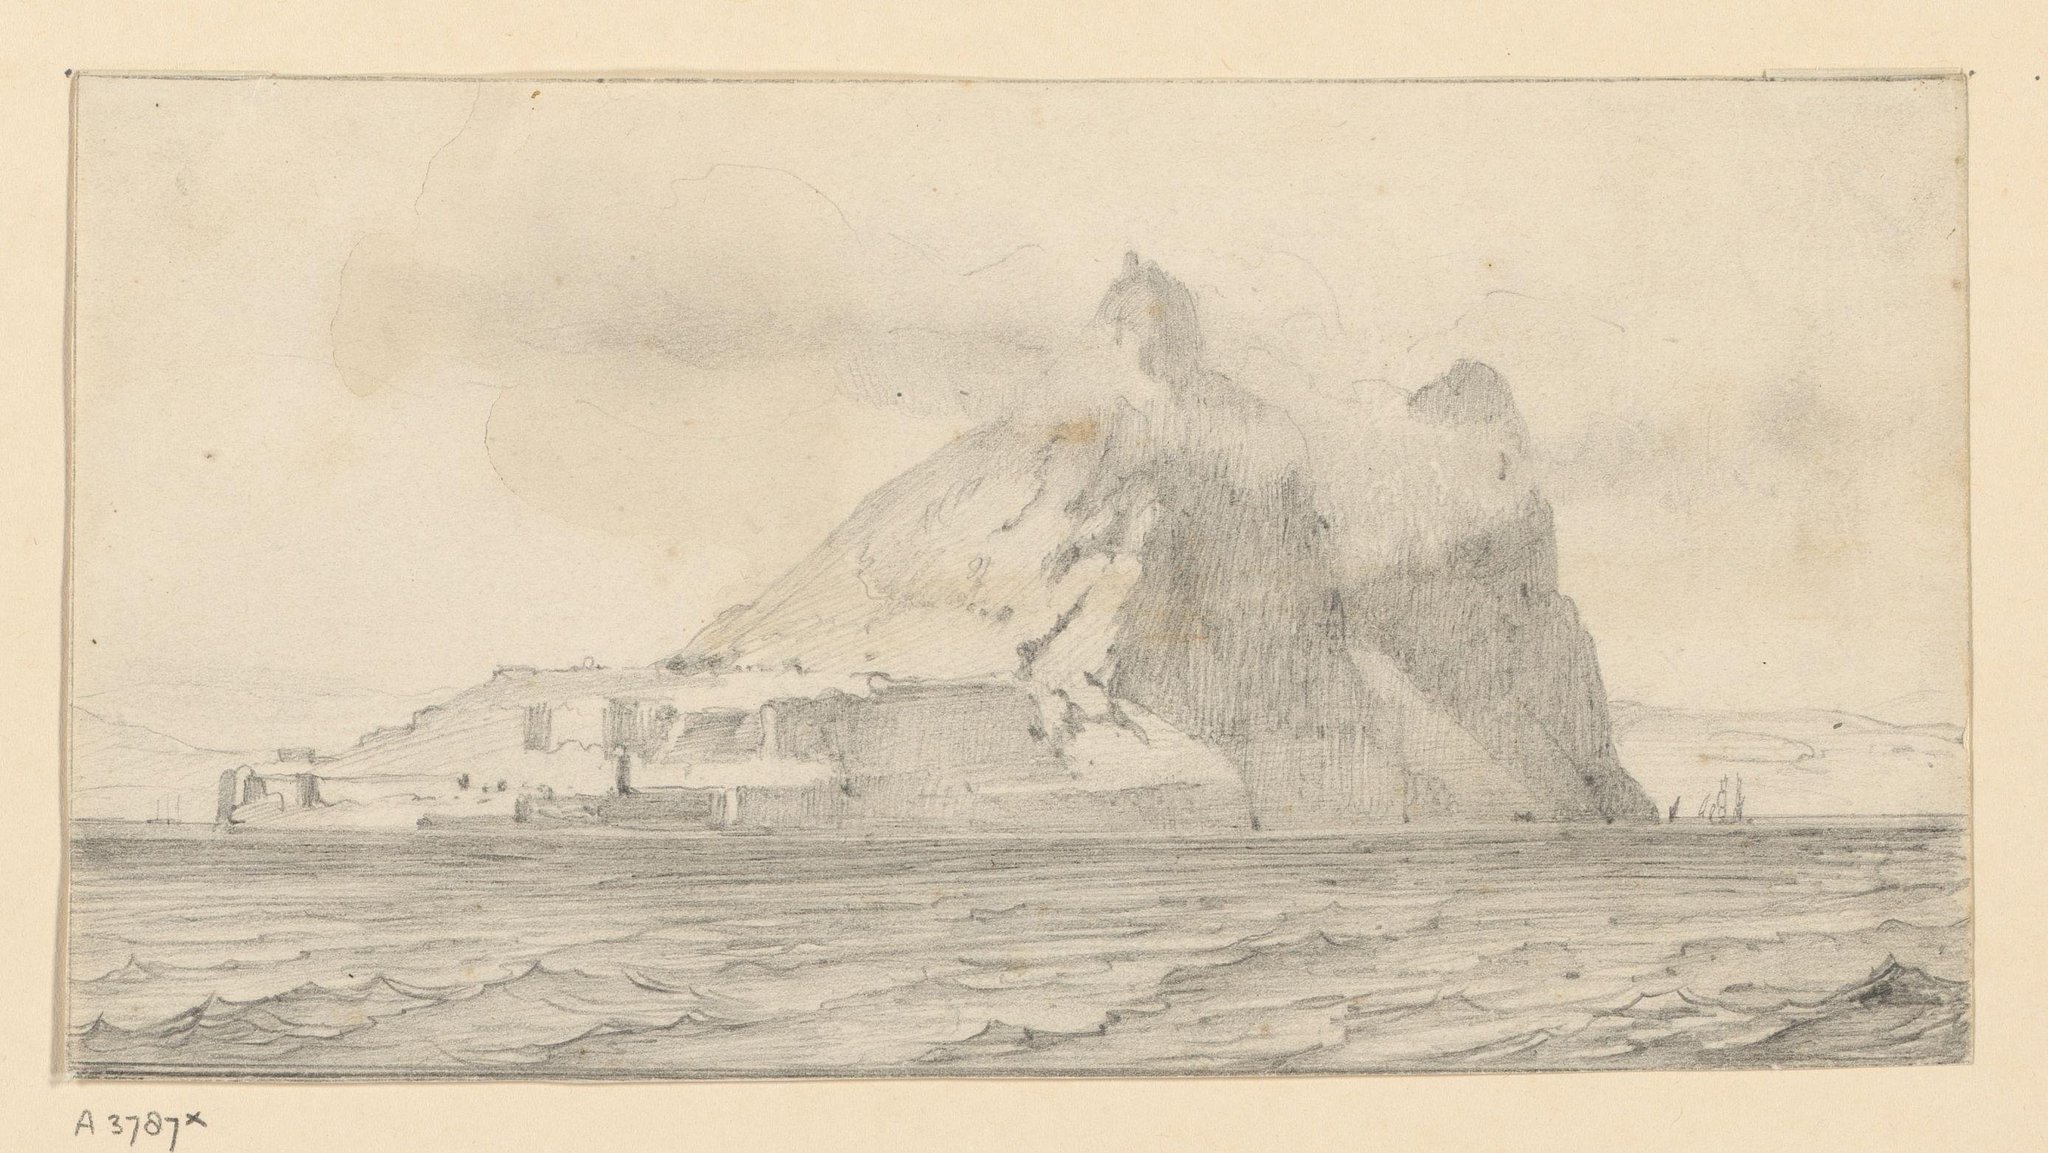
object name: drawing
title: Eiland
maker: willem anthonie van deventer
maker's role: draughtsman, painter, print maker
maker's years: 1824-1893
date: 1834-1893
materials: paper, pencil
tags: city-view, and landscape with man-made constructions